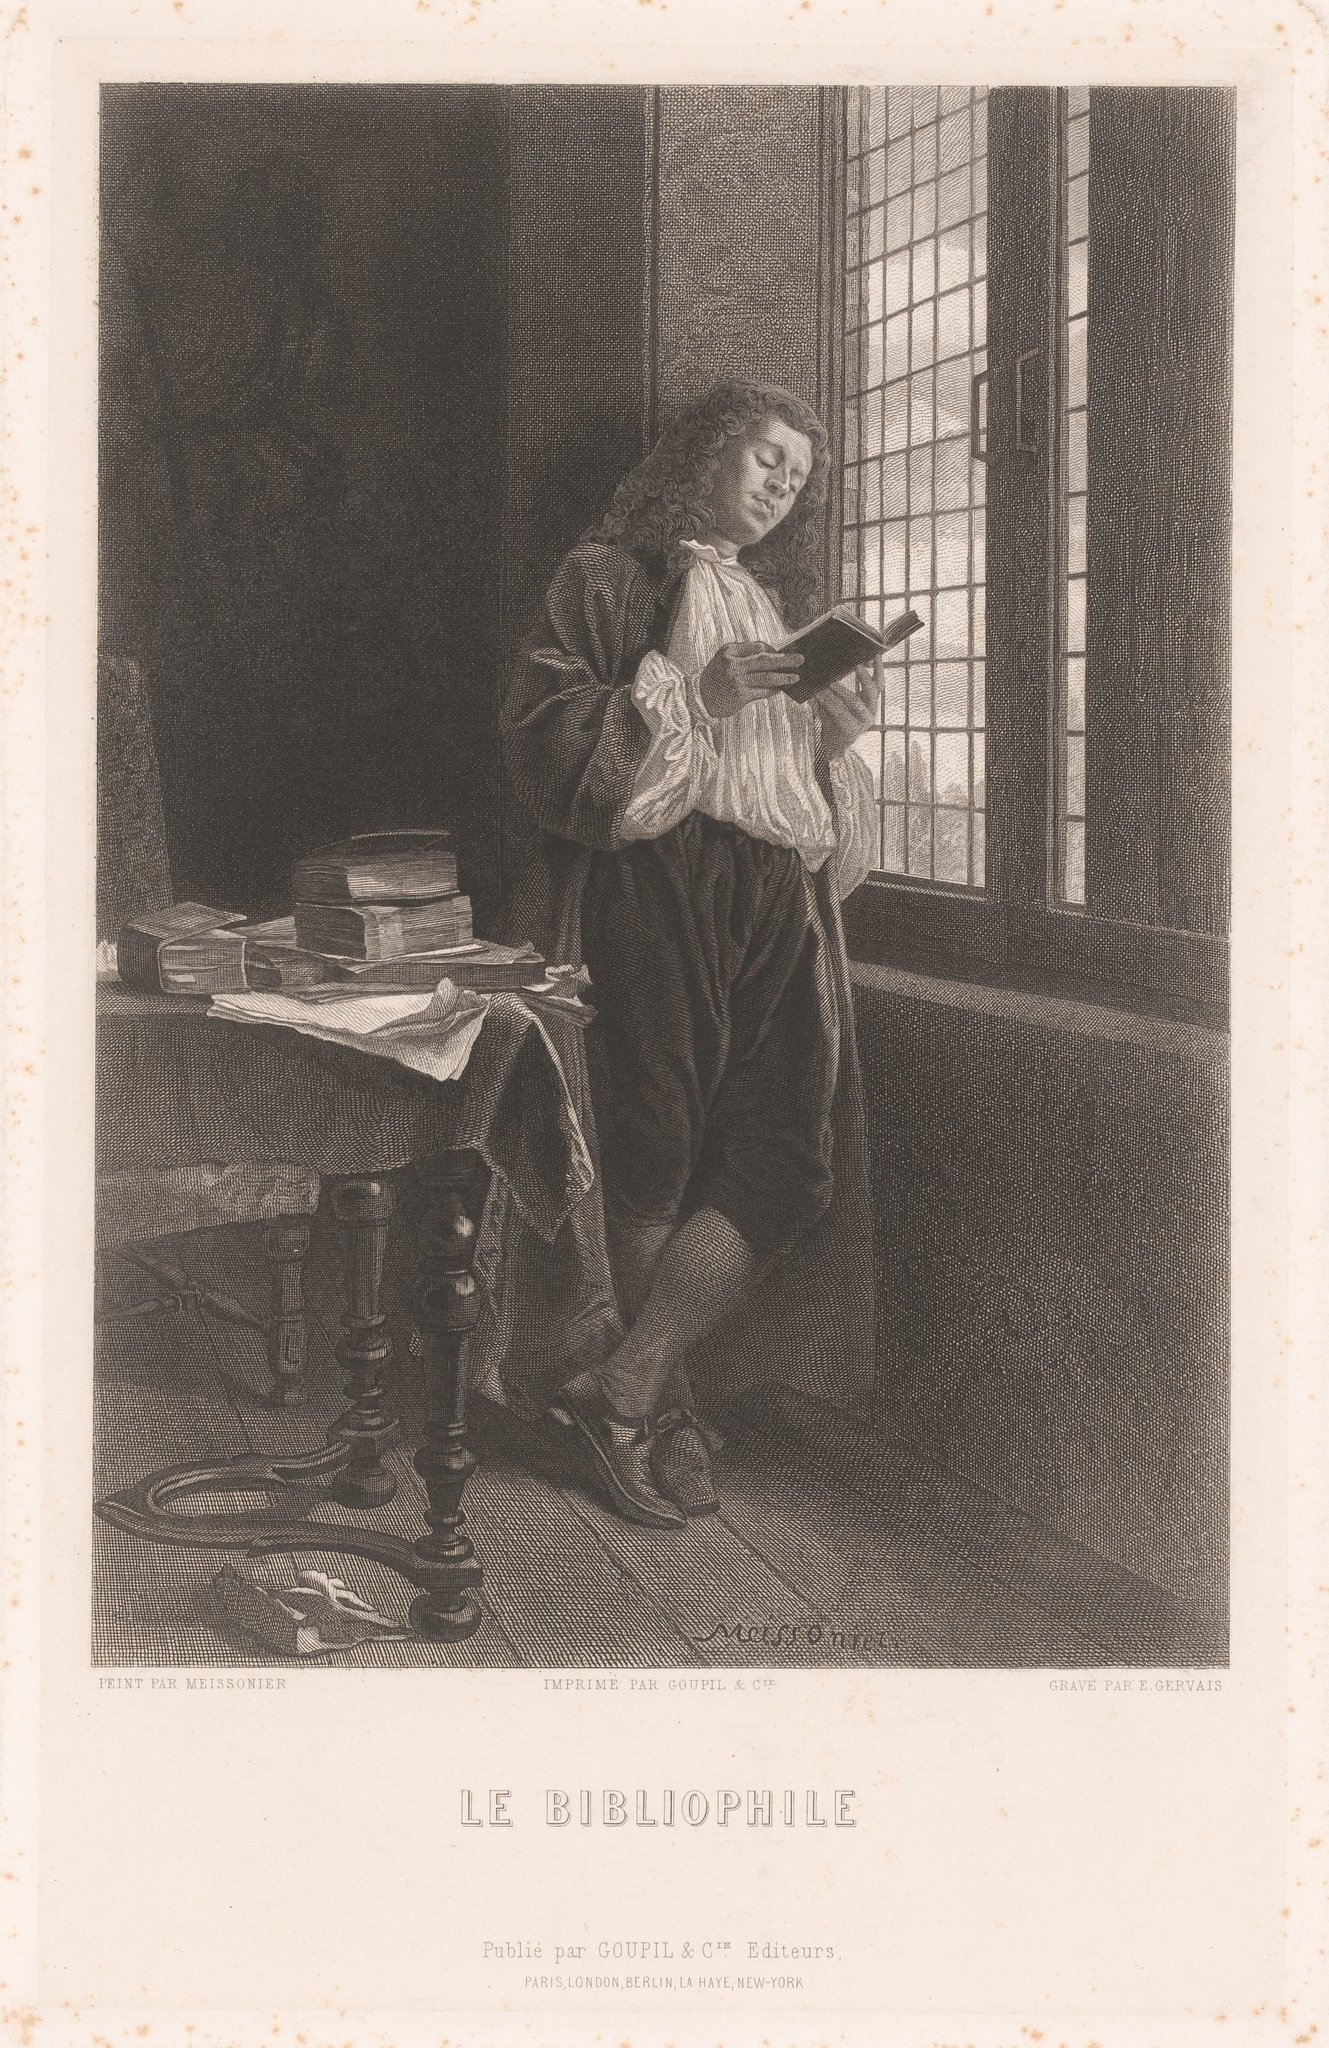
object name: print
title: Le bibliophile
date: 1846-1880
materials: paper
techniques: engraving, etching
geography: new york city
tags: reading, study; 'studiolo'; library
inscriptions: collector's mark: Lugt 2228